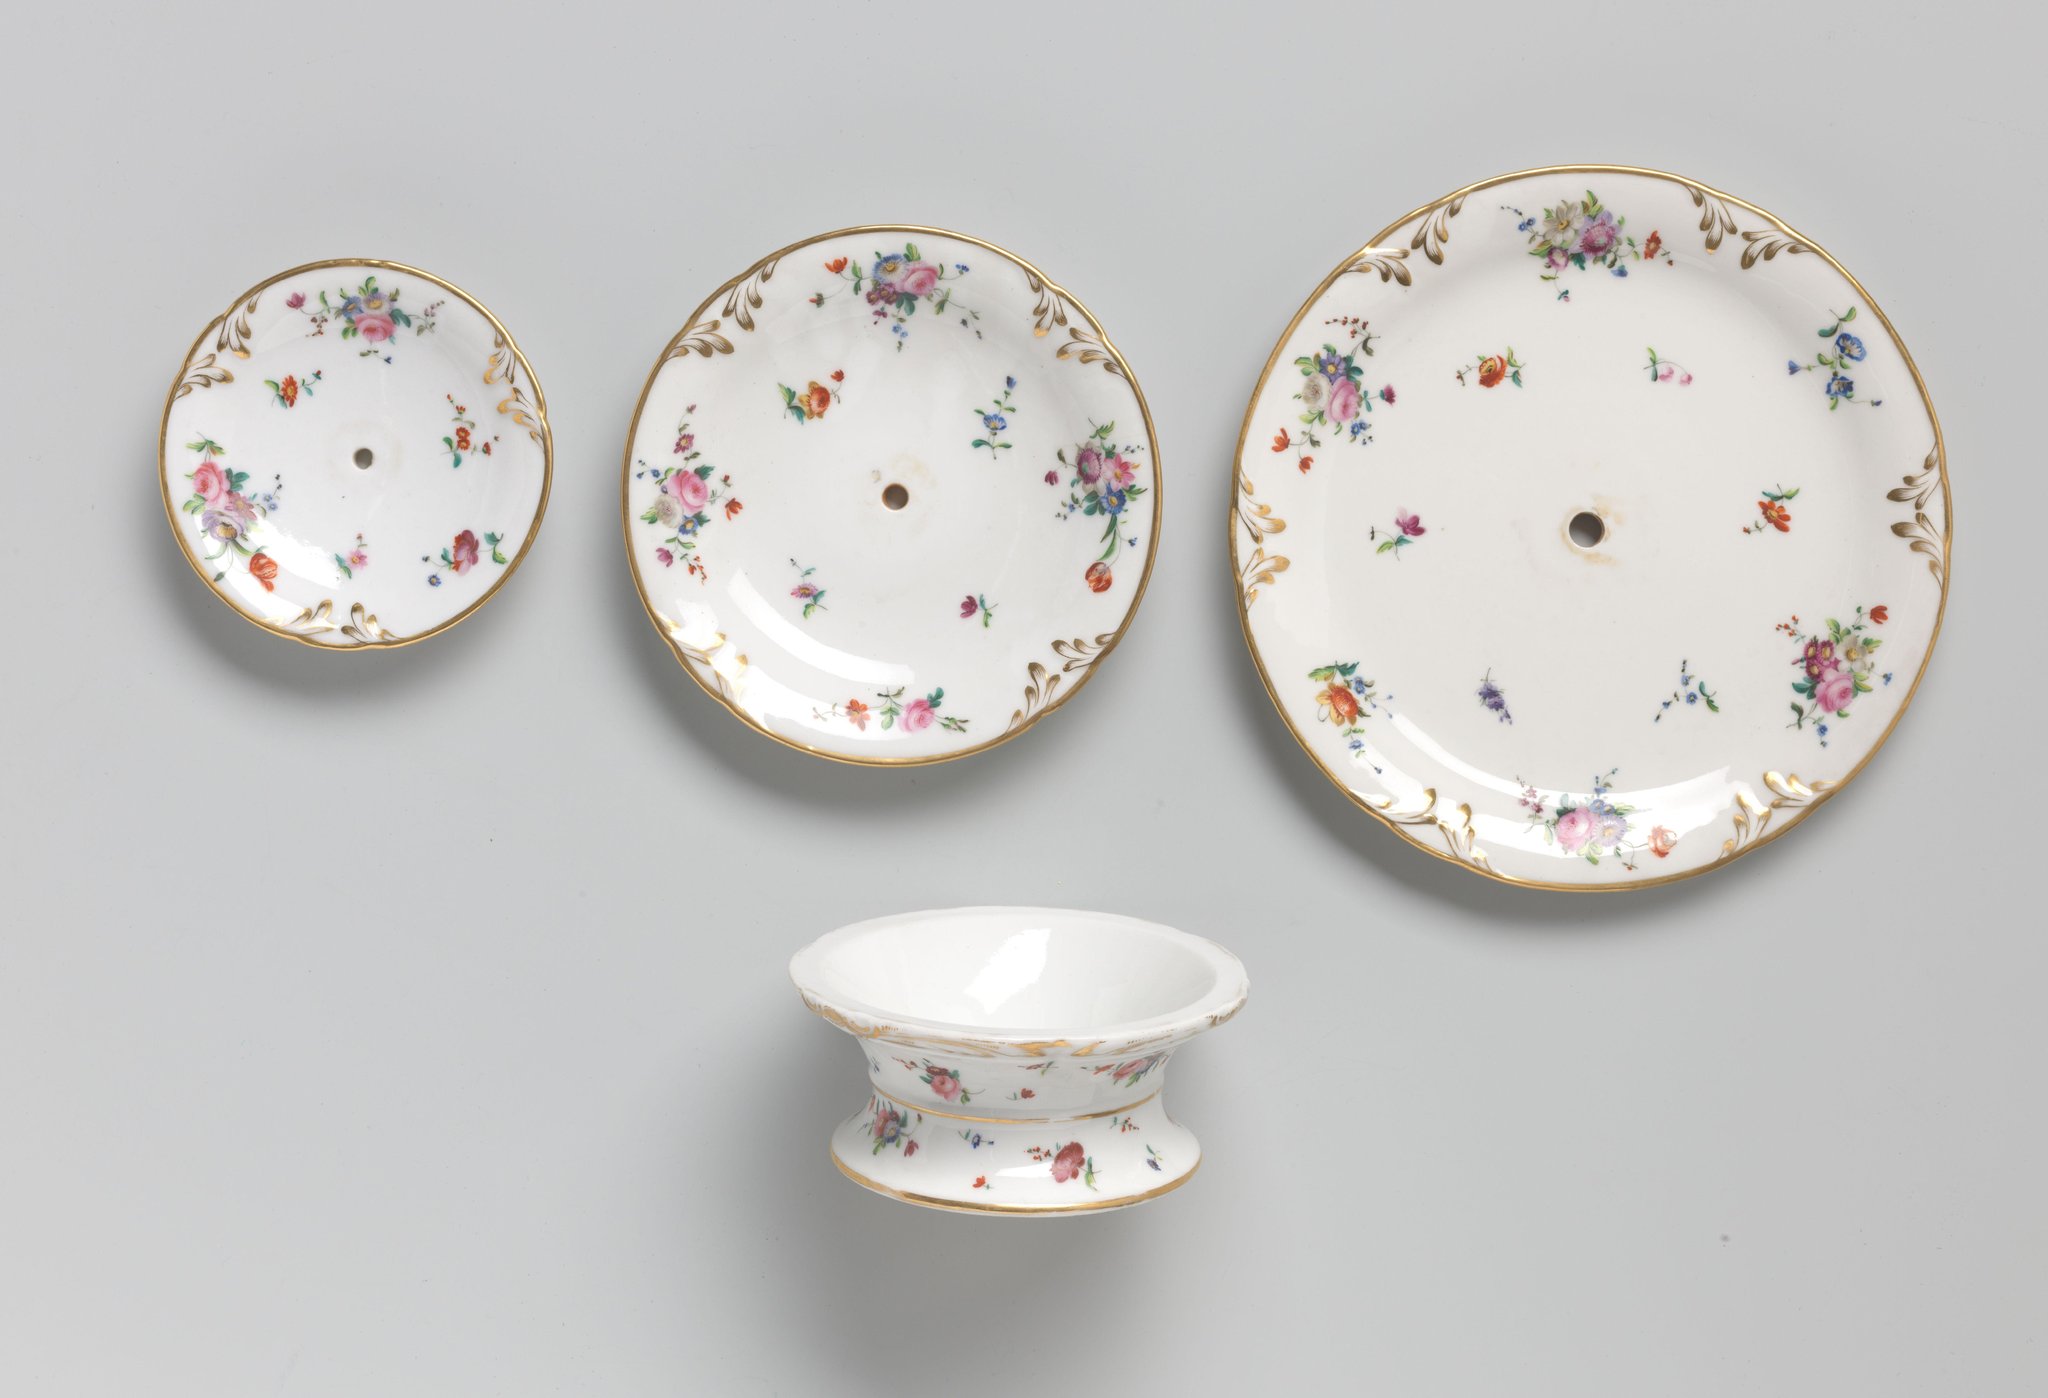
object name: spike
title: Baluster with iron rod of an etagere with bouquets and flower sprays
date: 1839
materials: glaze, gold, paint, porcelain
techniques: firing, forming, gilding, turning, vitrification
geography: paris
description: Het bovenste, balustervormige deel van de steel van een étagère van porselein, beschilderd op het glazuur in blauw, rood, roze, groen, geel, paars, zwart en goud. Bevestigd aan het porselein een ijzeren pin, om alle delen te verbinden. Het porseleinen deel is versierd met boeketten van verschillende bloemen, strooibloemen en gouden lijnen. Aan de bovenzijde een draagring in de vorm van een bladerkrans.